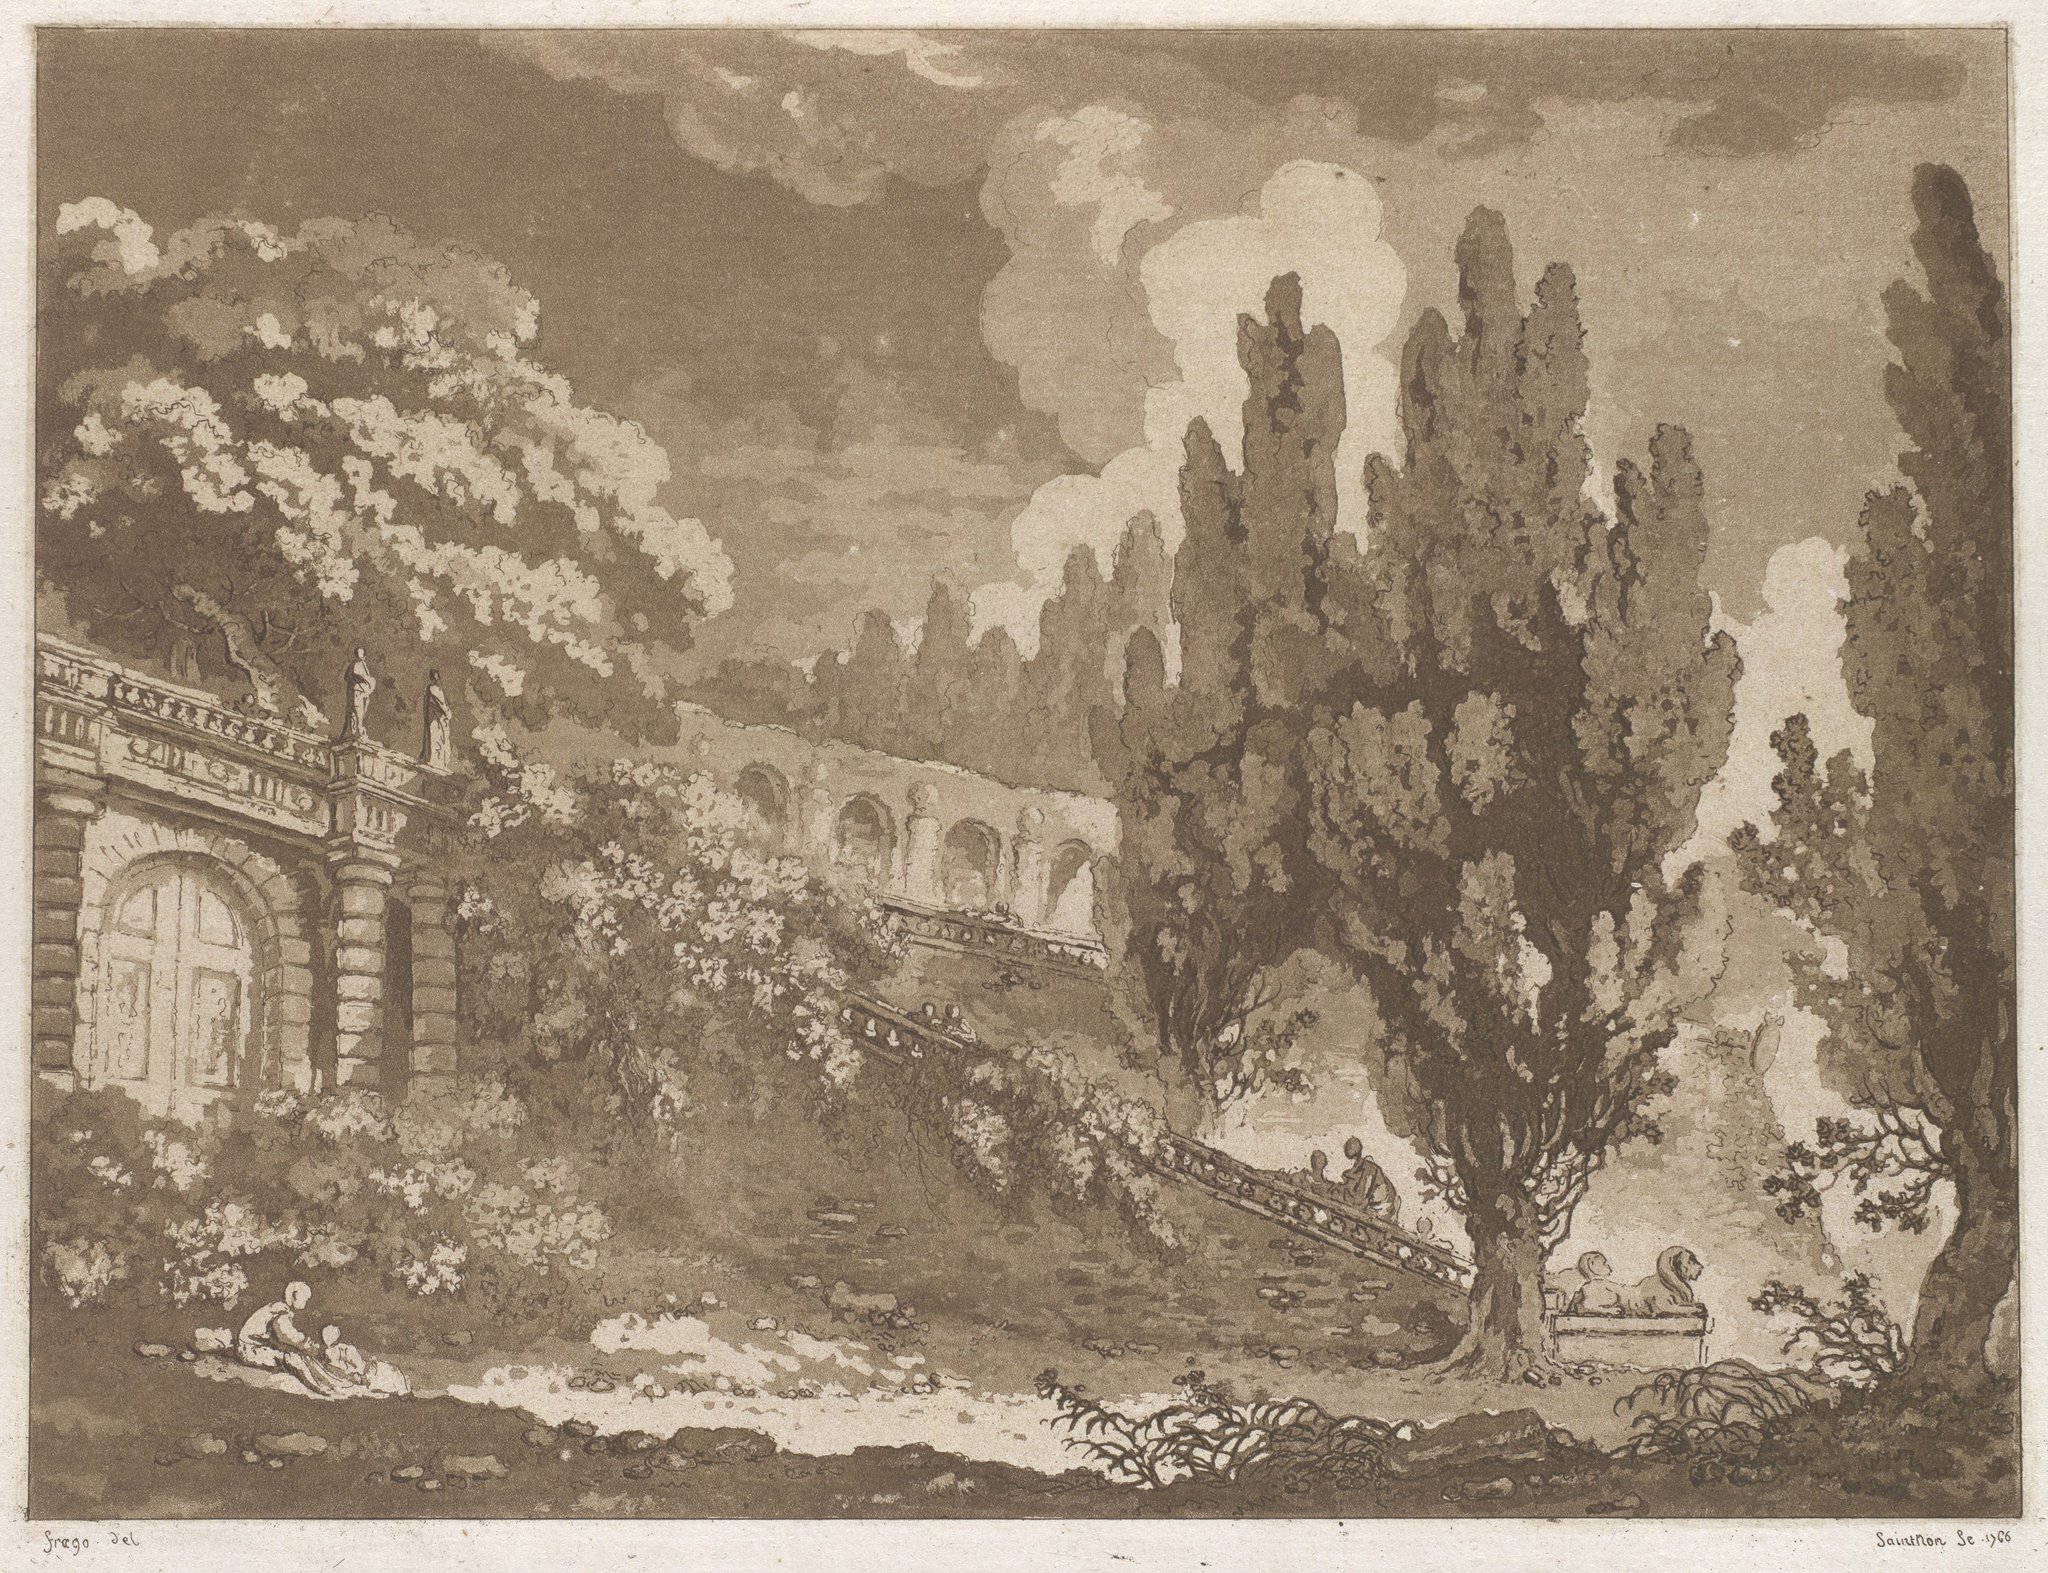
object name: print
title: La Jeu de la Palette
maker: jean claude richard, abbé de saint-non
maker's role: artist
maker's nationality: french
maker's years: 1727-1791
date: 1766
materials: ink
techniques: aquatint, printing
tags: landscapes